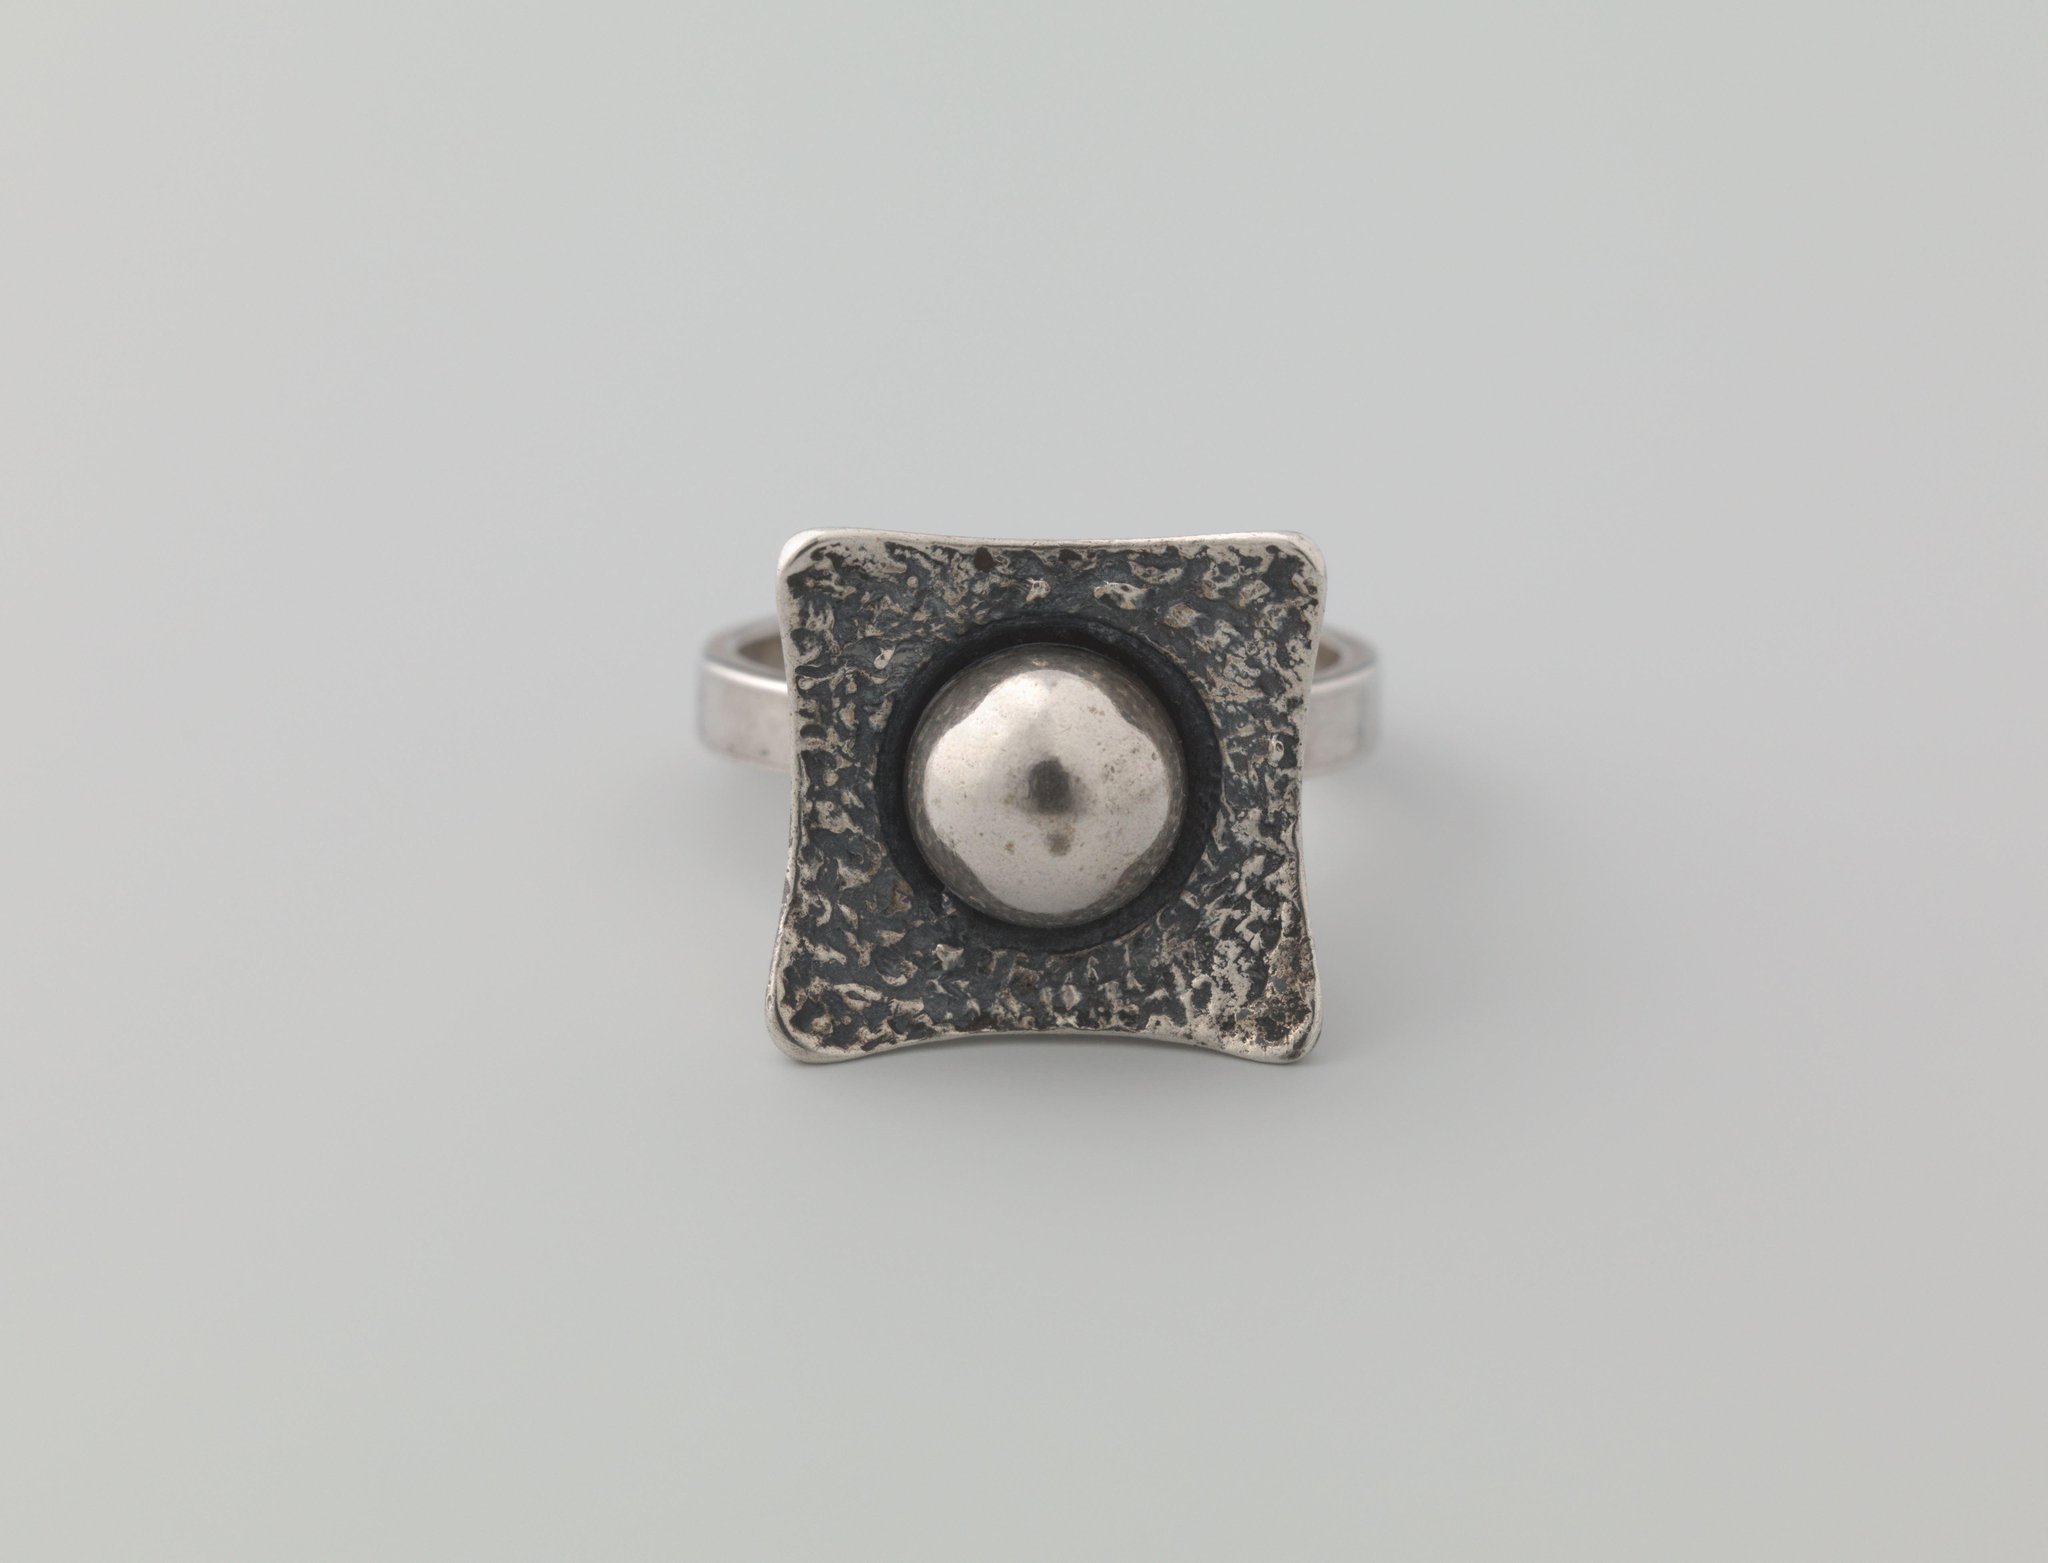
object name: ring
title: Tienerring met vierkante knop met daarin een cirkel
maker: Anonymous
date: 1960-1970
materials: silver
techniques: blackening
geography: netherlands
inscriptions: alloy mark: ‘zwaard 835’, maker's mark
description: Tienerring met vierkante knop met daarin een cirkel. Het vierkant heeft afgeronde hoeken en een ruwe gezwarte textuur. De cirkel daarbinnen is glad.